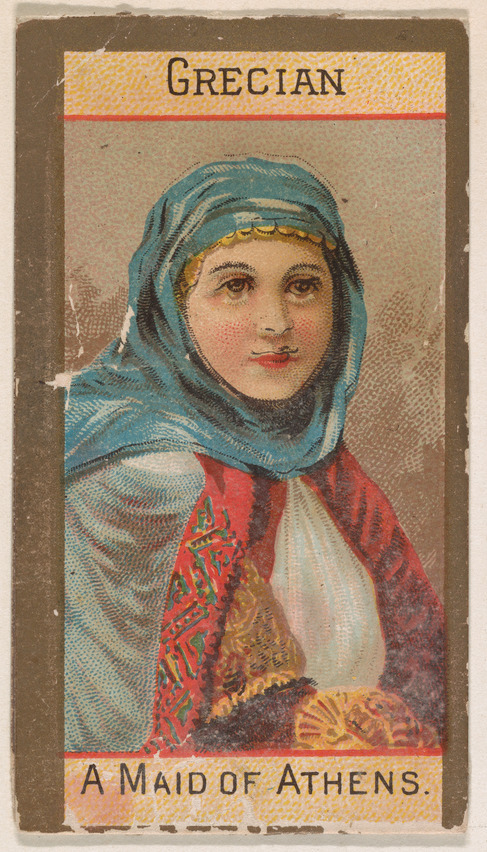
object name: print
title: Greecian, A Maid of Athens, from Types of Nationalities (N240) issued by Kinney Bros.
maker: kinney brothers tobacco company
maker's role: publisher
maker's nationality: american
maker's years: 1869-2011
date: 1890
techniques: color lithograph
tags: women